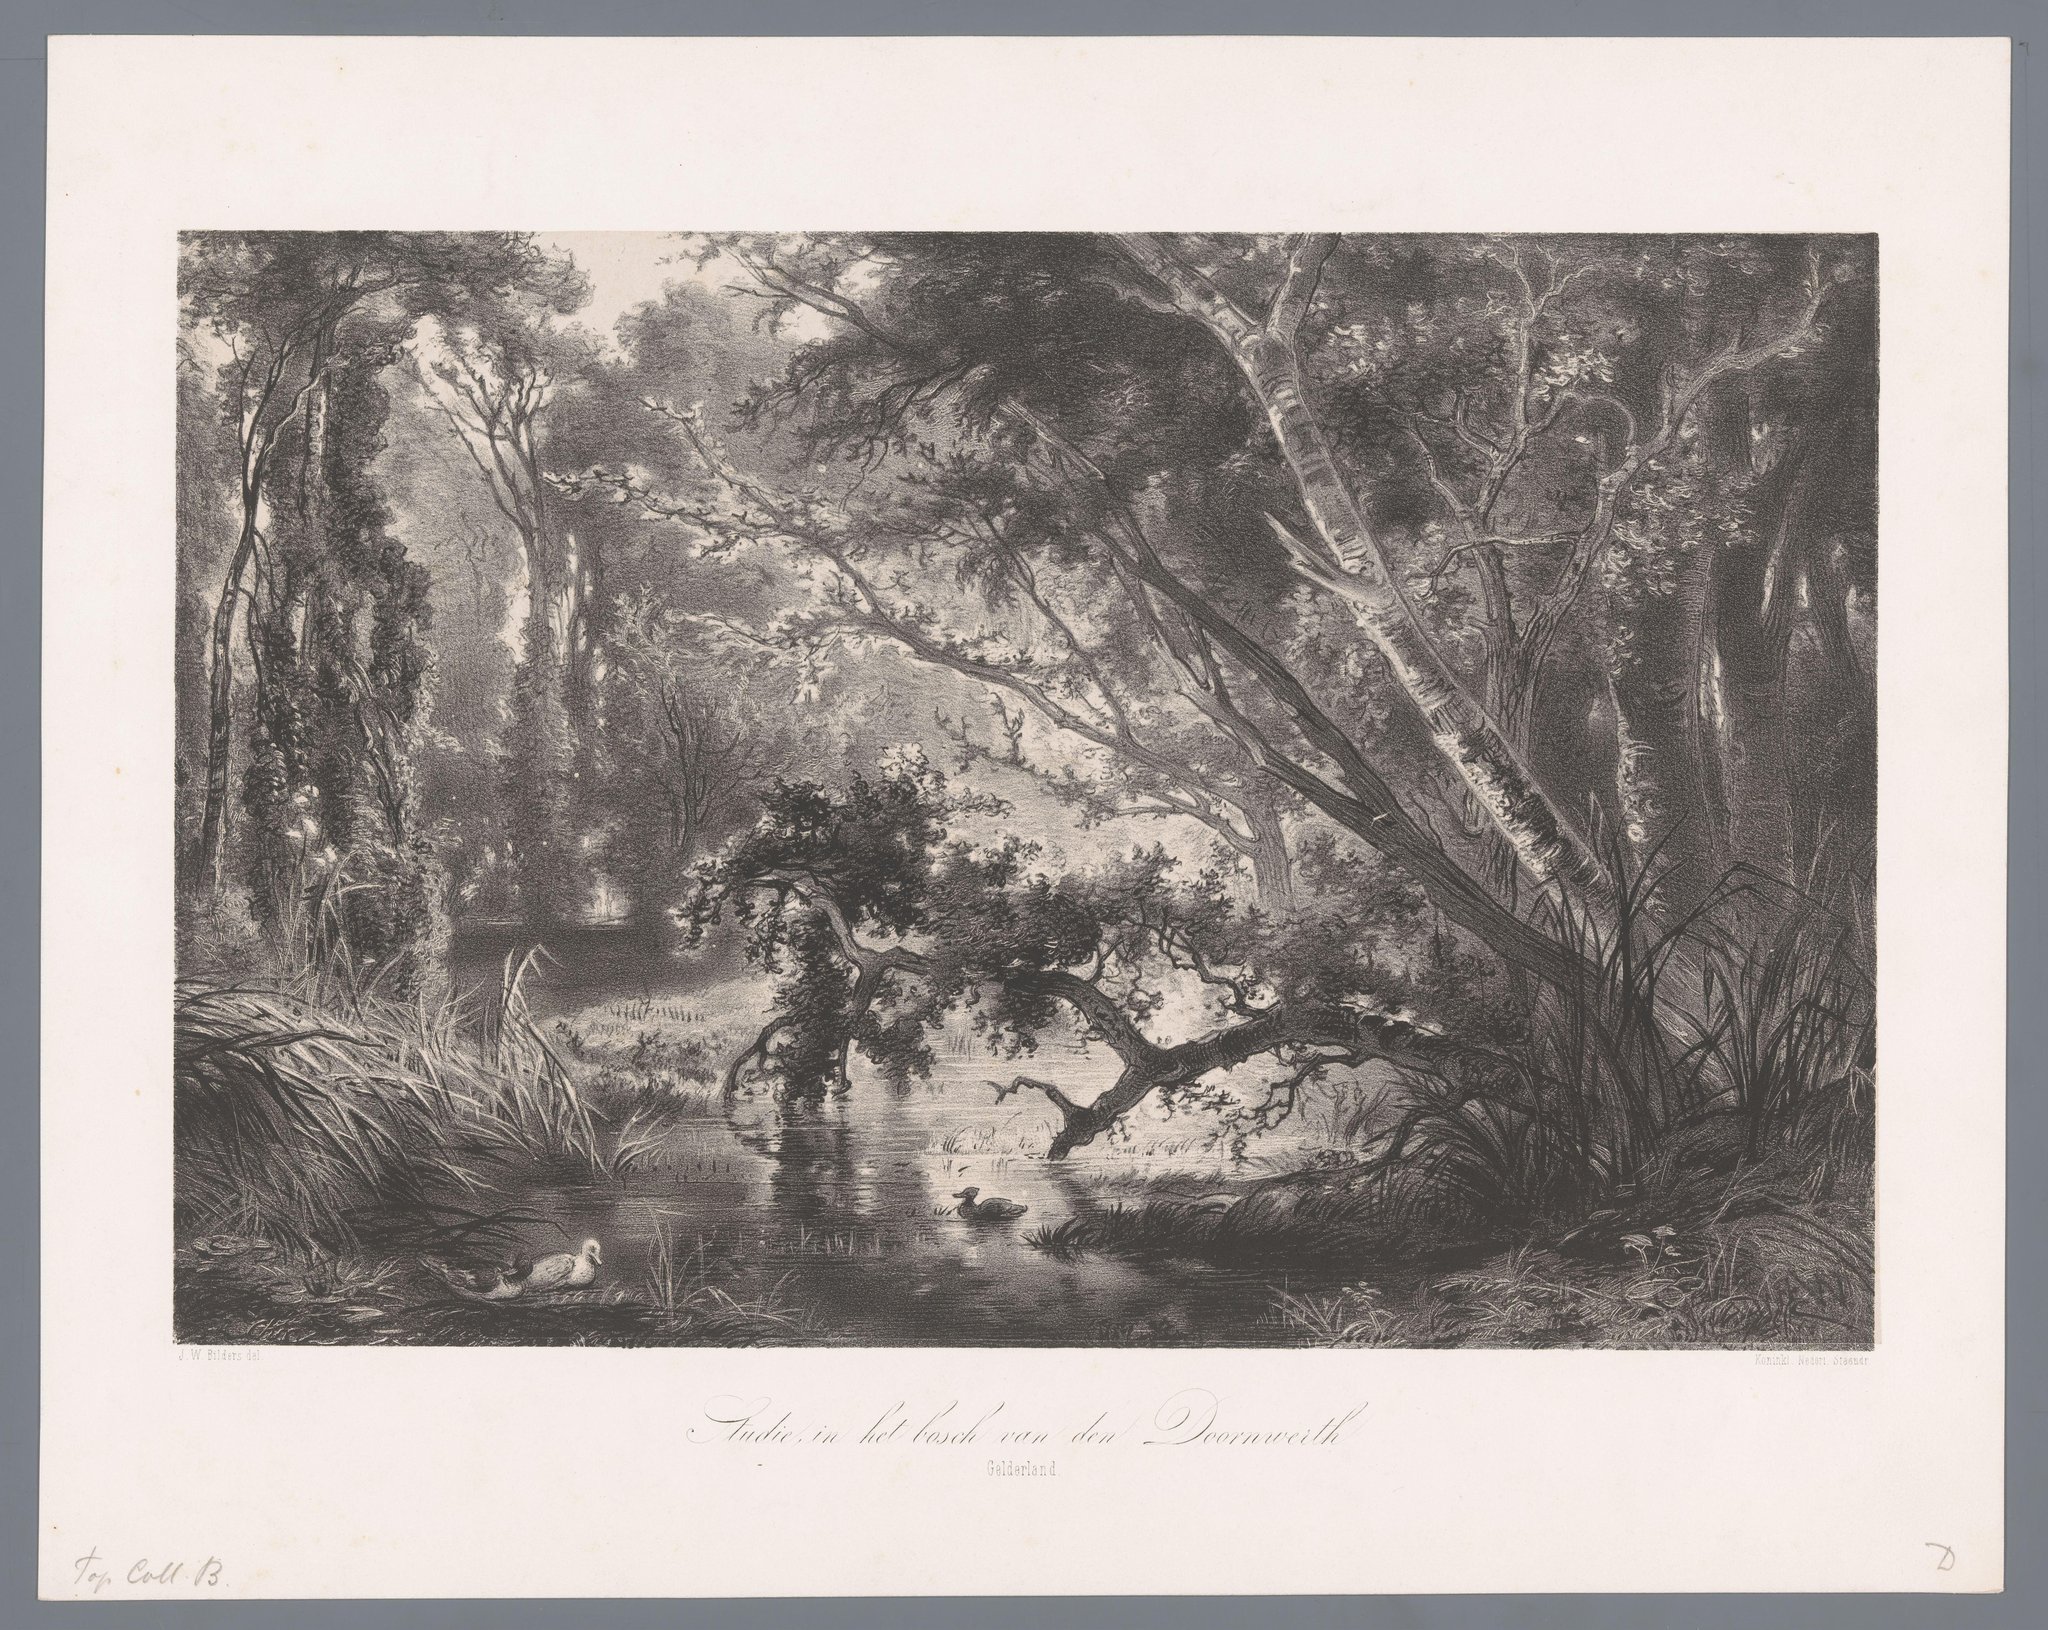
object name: print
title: Studie, in het bosch van den Doornwerth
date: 1867-1874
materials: paper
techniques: tone lithography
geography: the hague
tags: forest, wood, pool, puddle, water-birds: duck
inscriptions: collector's mark: Lugt 2228, collector's mark: Lugt 2760